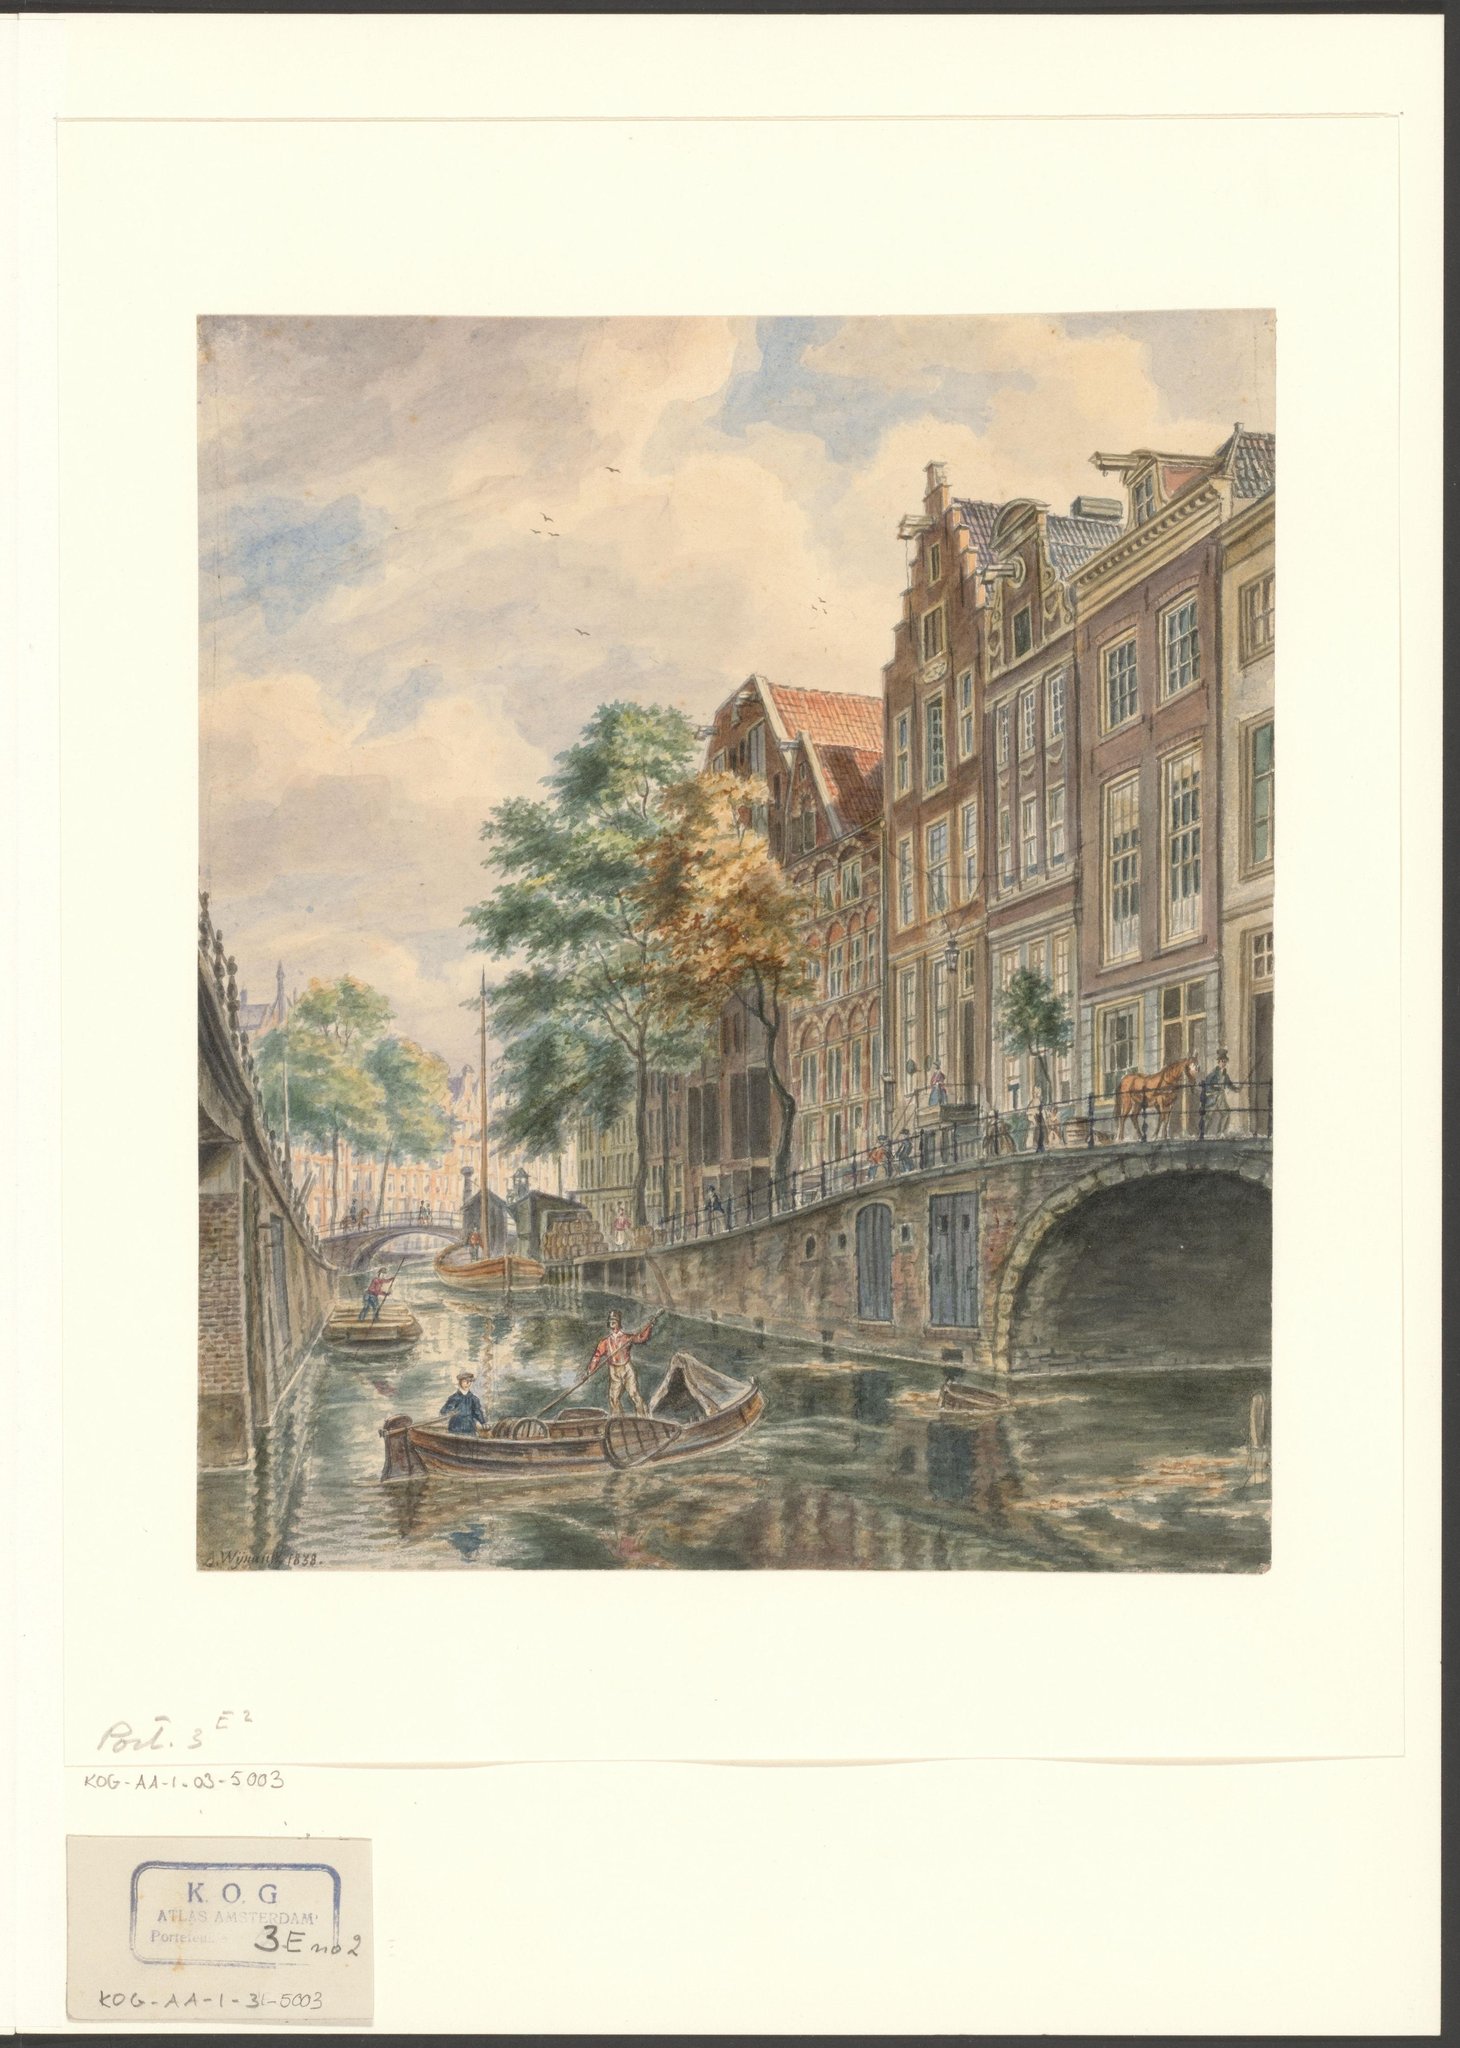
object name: drawing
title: Gezicht op de Nieuwezijds Achterburgwal met brouwerij De Hooiberg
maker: augustus wijnantz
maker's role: draughtsman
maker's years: 1795-1848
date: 1838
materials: ink, paper, pencil, watercolor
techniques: brush, pen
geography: amsterdam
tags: city-view in general; 'veduta', canal, bridge in city across river, canal, etc., street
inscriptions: collector's mark: ‘3E’ Lugt 1641b, inscription: ‘nieuwe zijds achterburgwal / te Amsterdam’, inscription: ‘Port. 3E2’, signature and date: ‘A. Wijnantz 1838.’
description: Onderwerpsrubriek binnen de Atlas Amsterdam: Achterburgwal, Nieuwezijds en - Oudezijds; Nieuwe Achtergracht, Achterweg, Akoleienstraat.